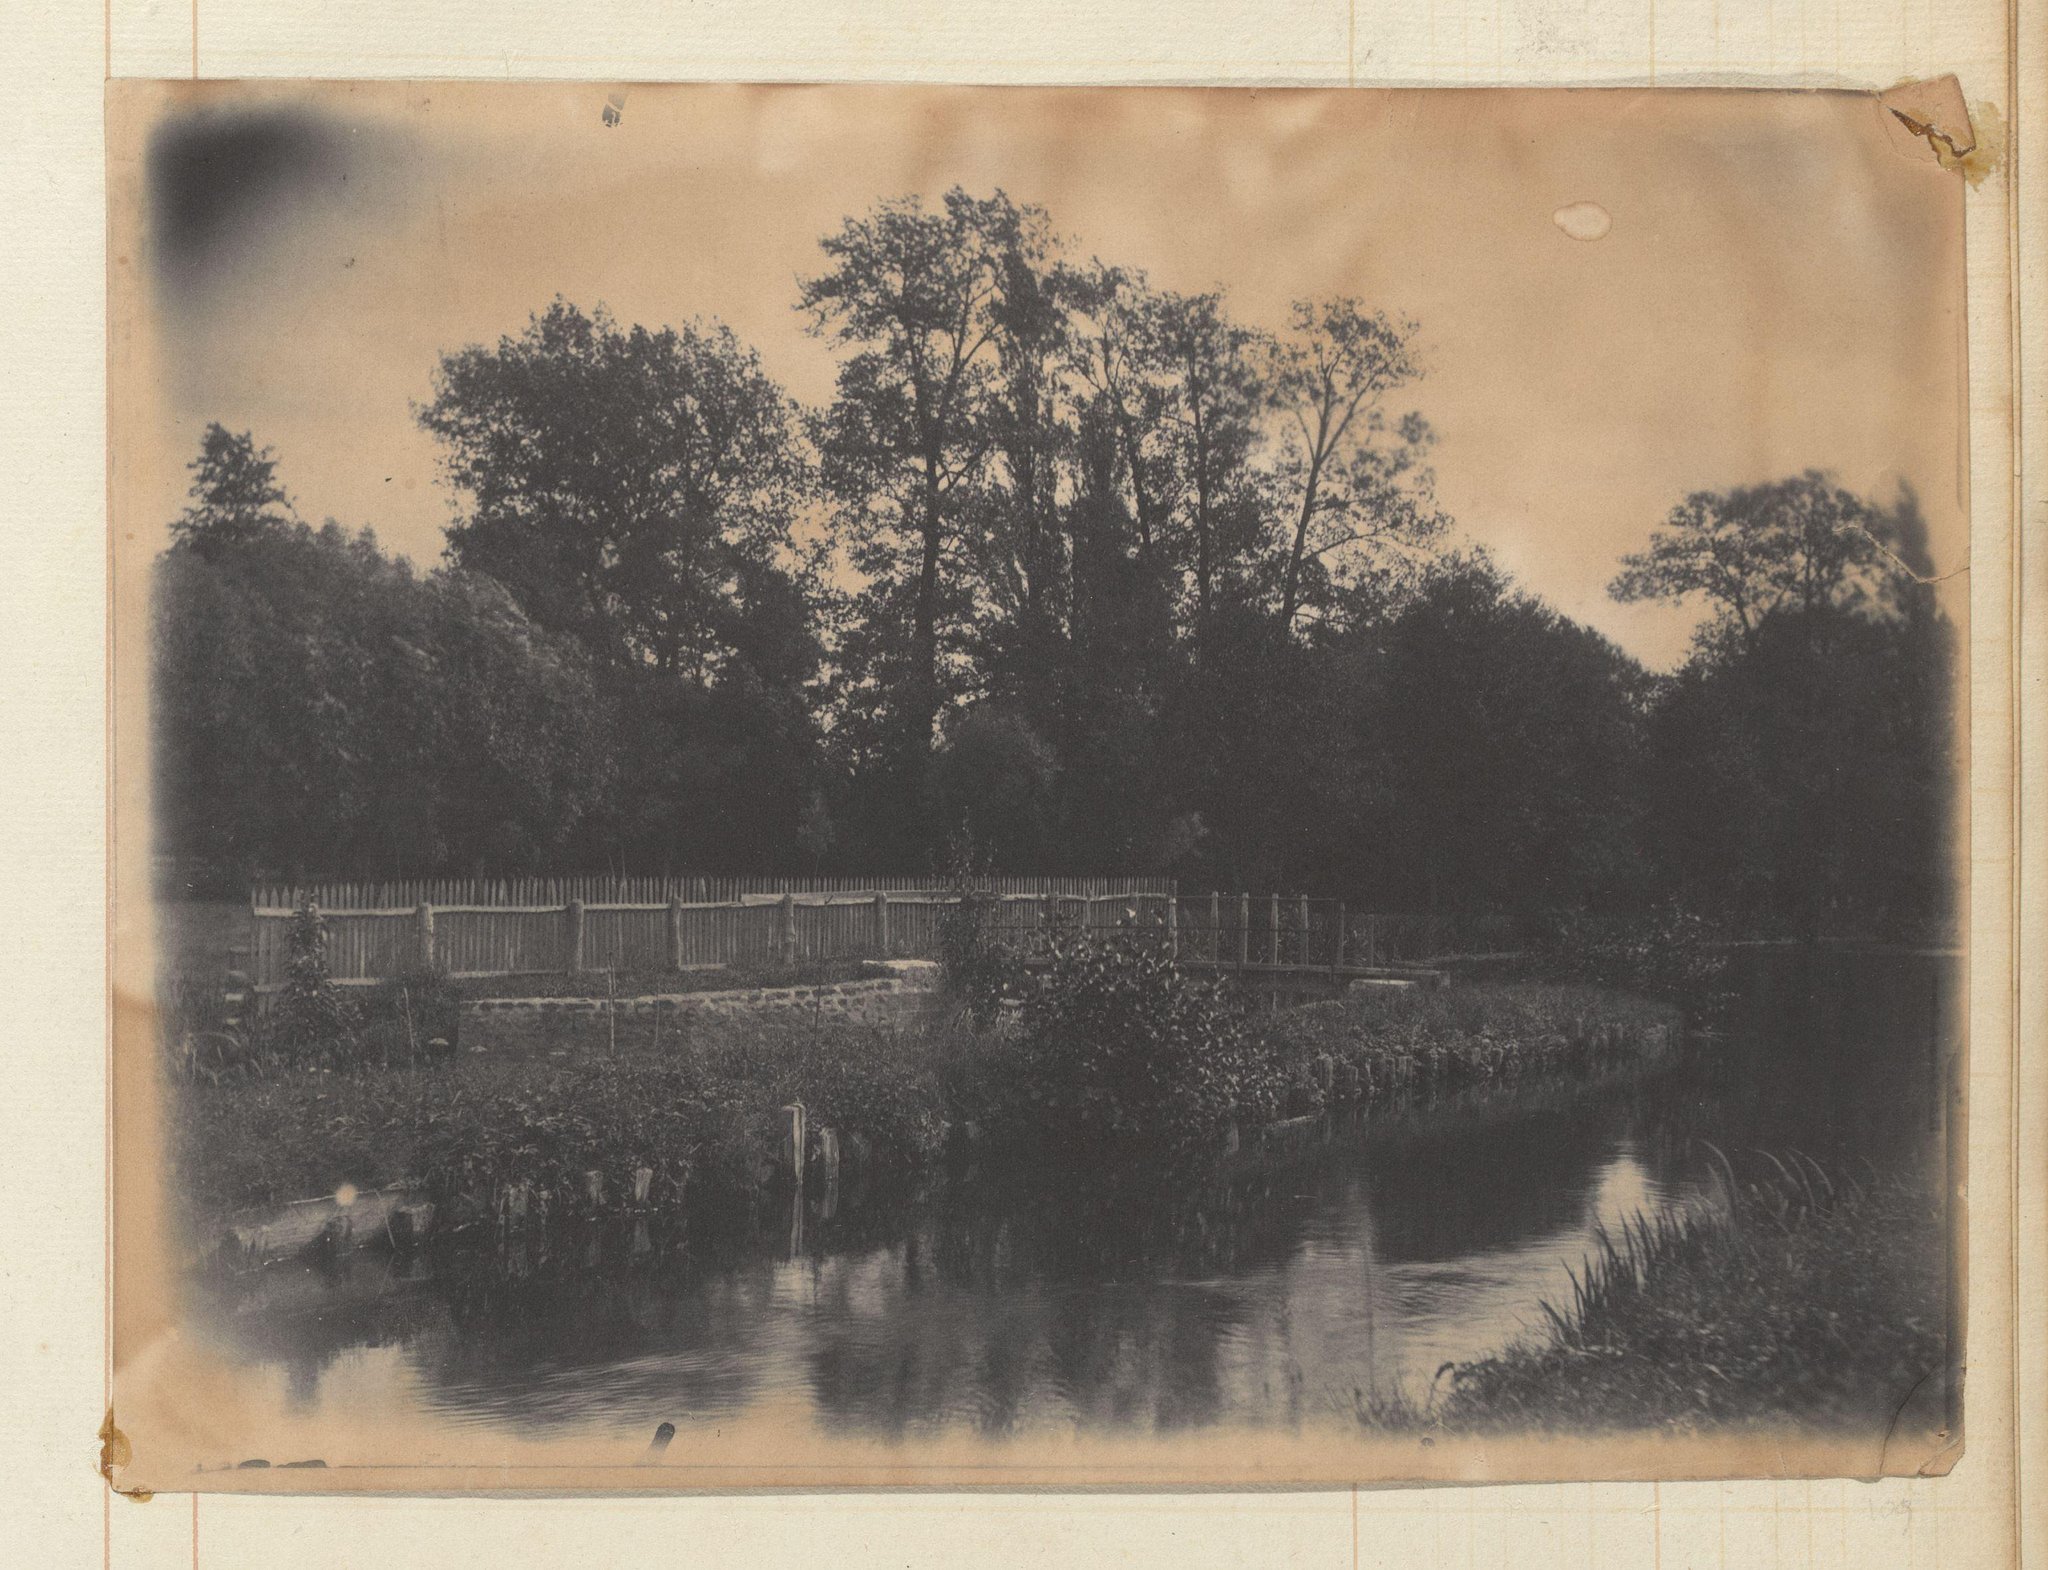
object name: photograph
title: Rivierlandschap met bomen, oevers en houten hek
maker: Anonymous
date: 1880-1900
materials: paper, photographic support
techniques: platinum process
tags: river bank, fence, wall, paling